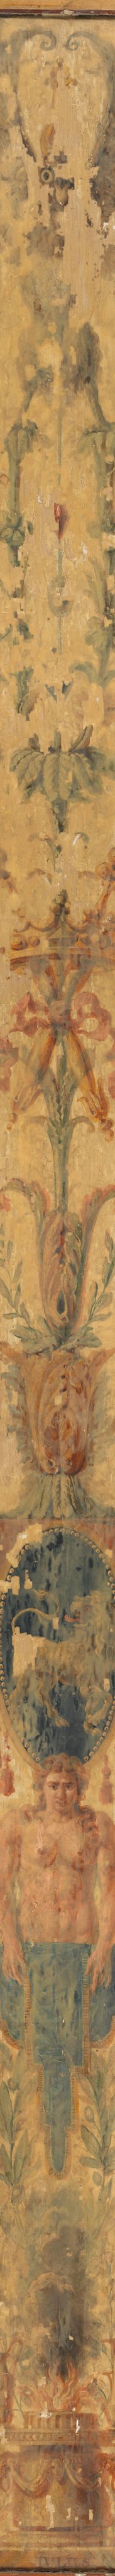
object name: decoratiestuk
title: July with the sign of Leo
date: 1790-1791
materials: oil, panel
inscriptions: inscription: ‘Julius’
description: Negen maanden met de tekens van de dierenriem: Juli met het teken van de Leeuw. Maakt deel uit van een groep decoraties met grotesken afkomstig uit het huis van J.A. Brentano aan de Herengracht. Waarschijnlijk vervaardigd naar ontwerpen van Giambattista Maderna.